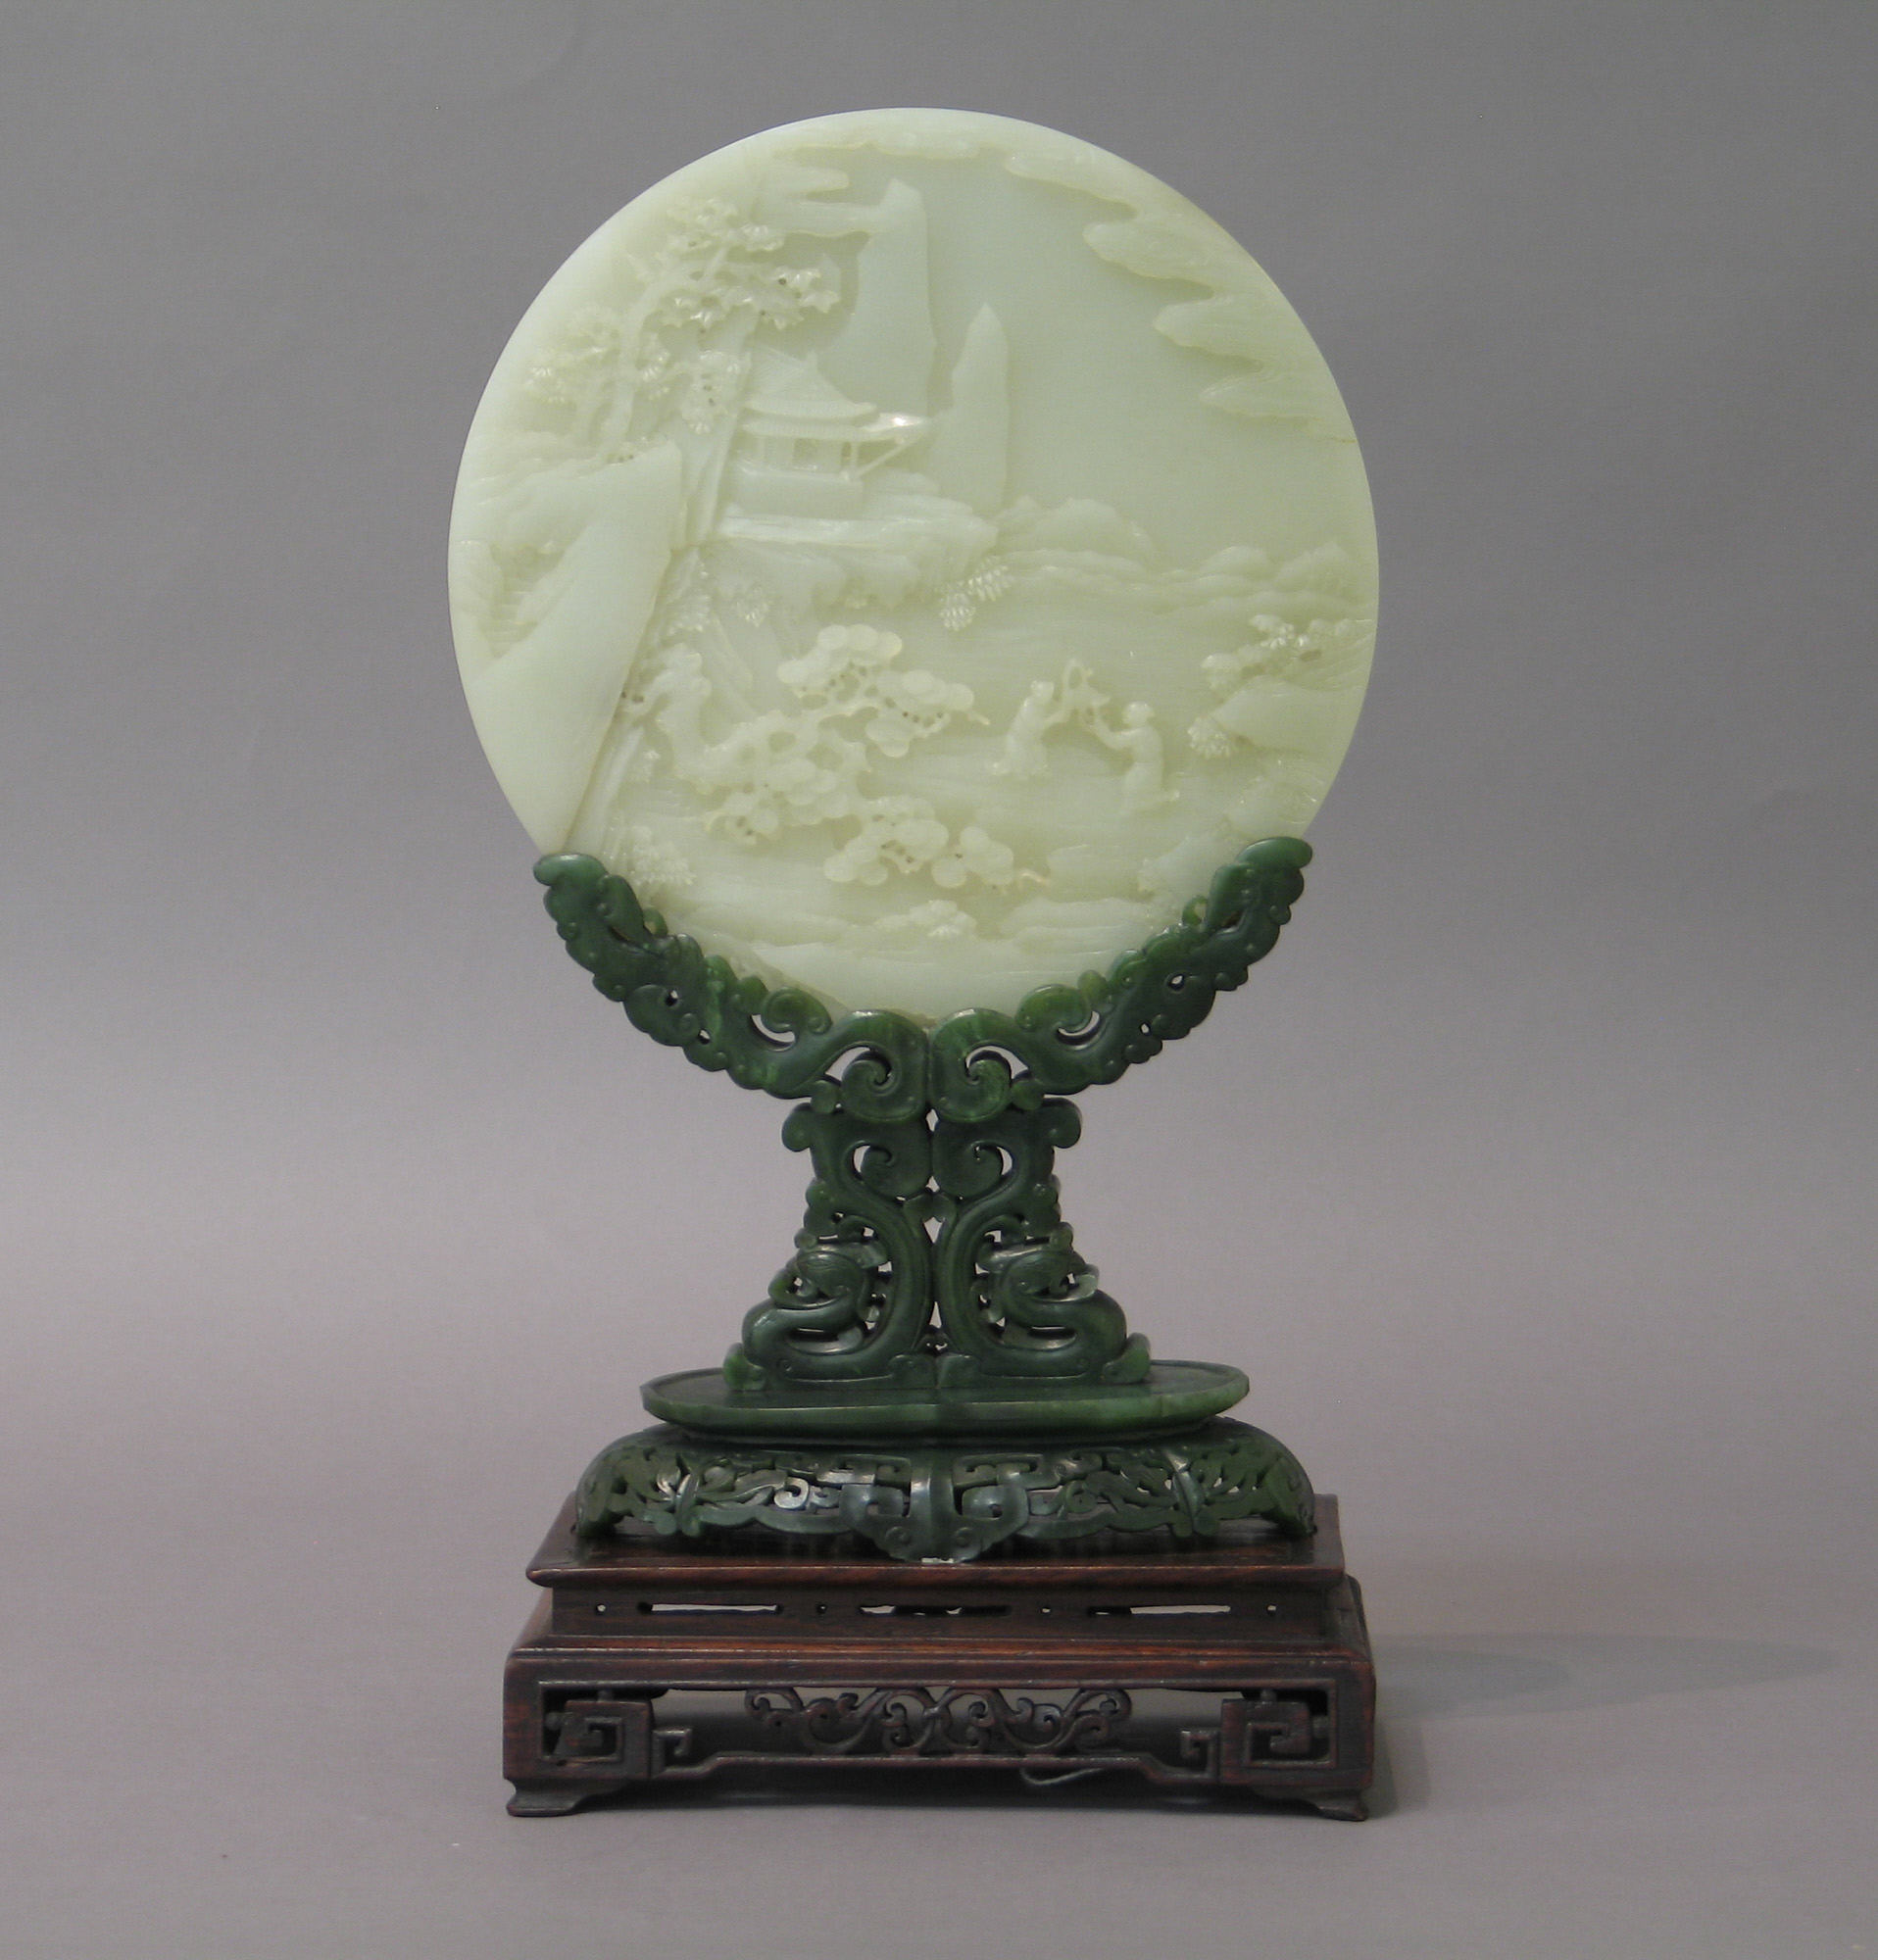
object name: table screen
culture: chinese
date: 1736-1795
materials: jade